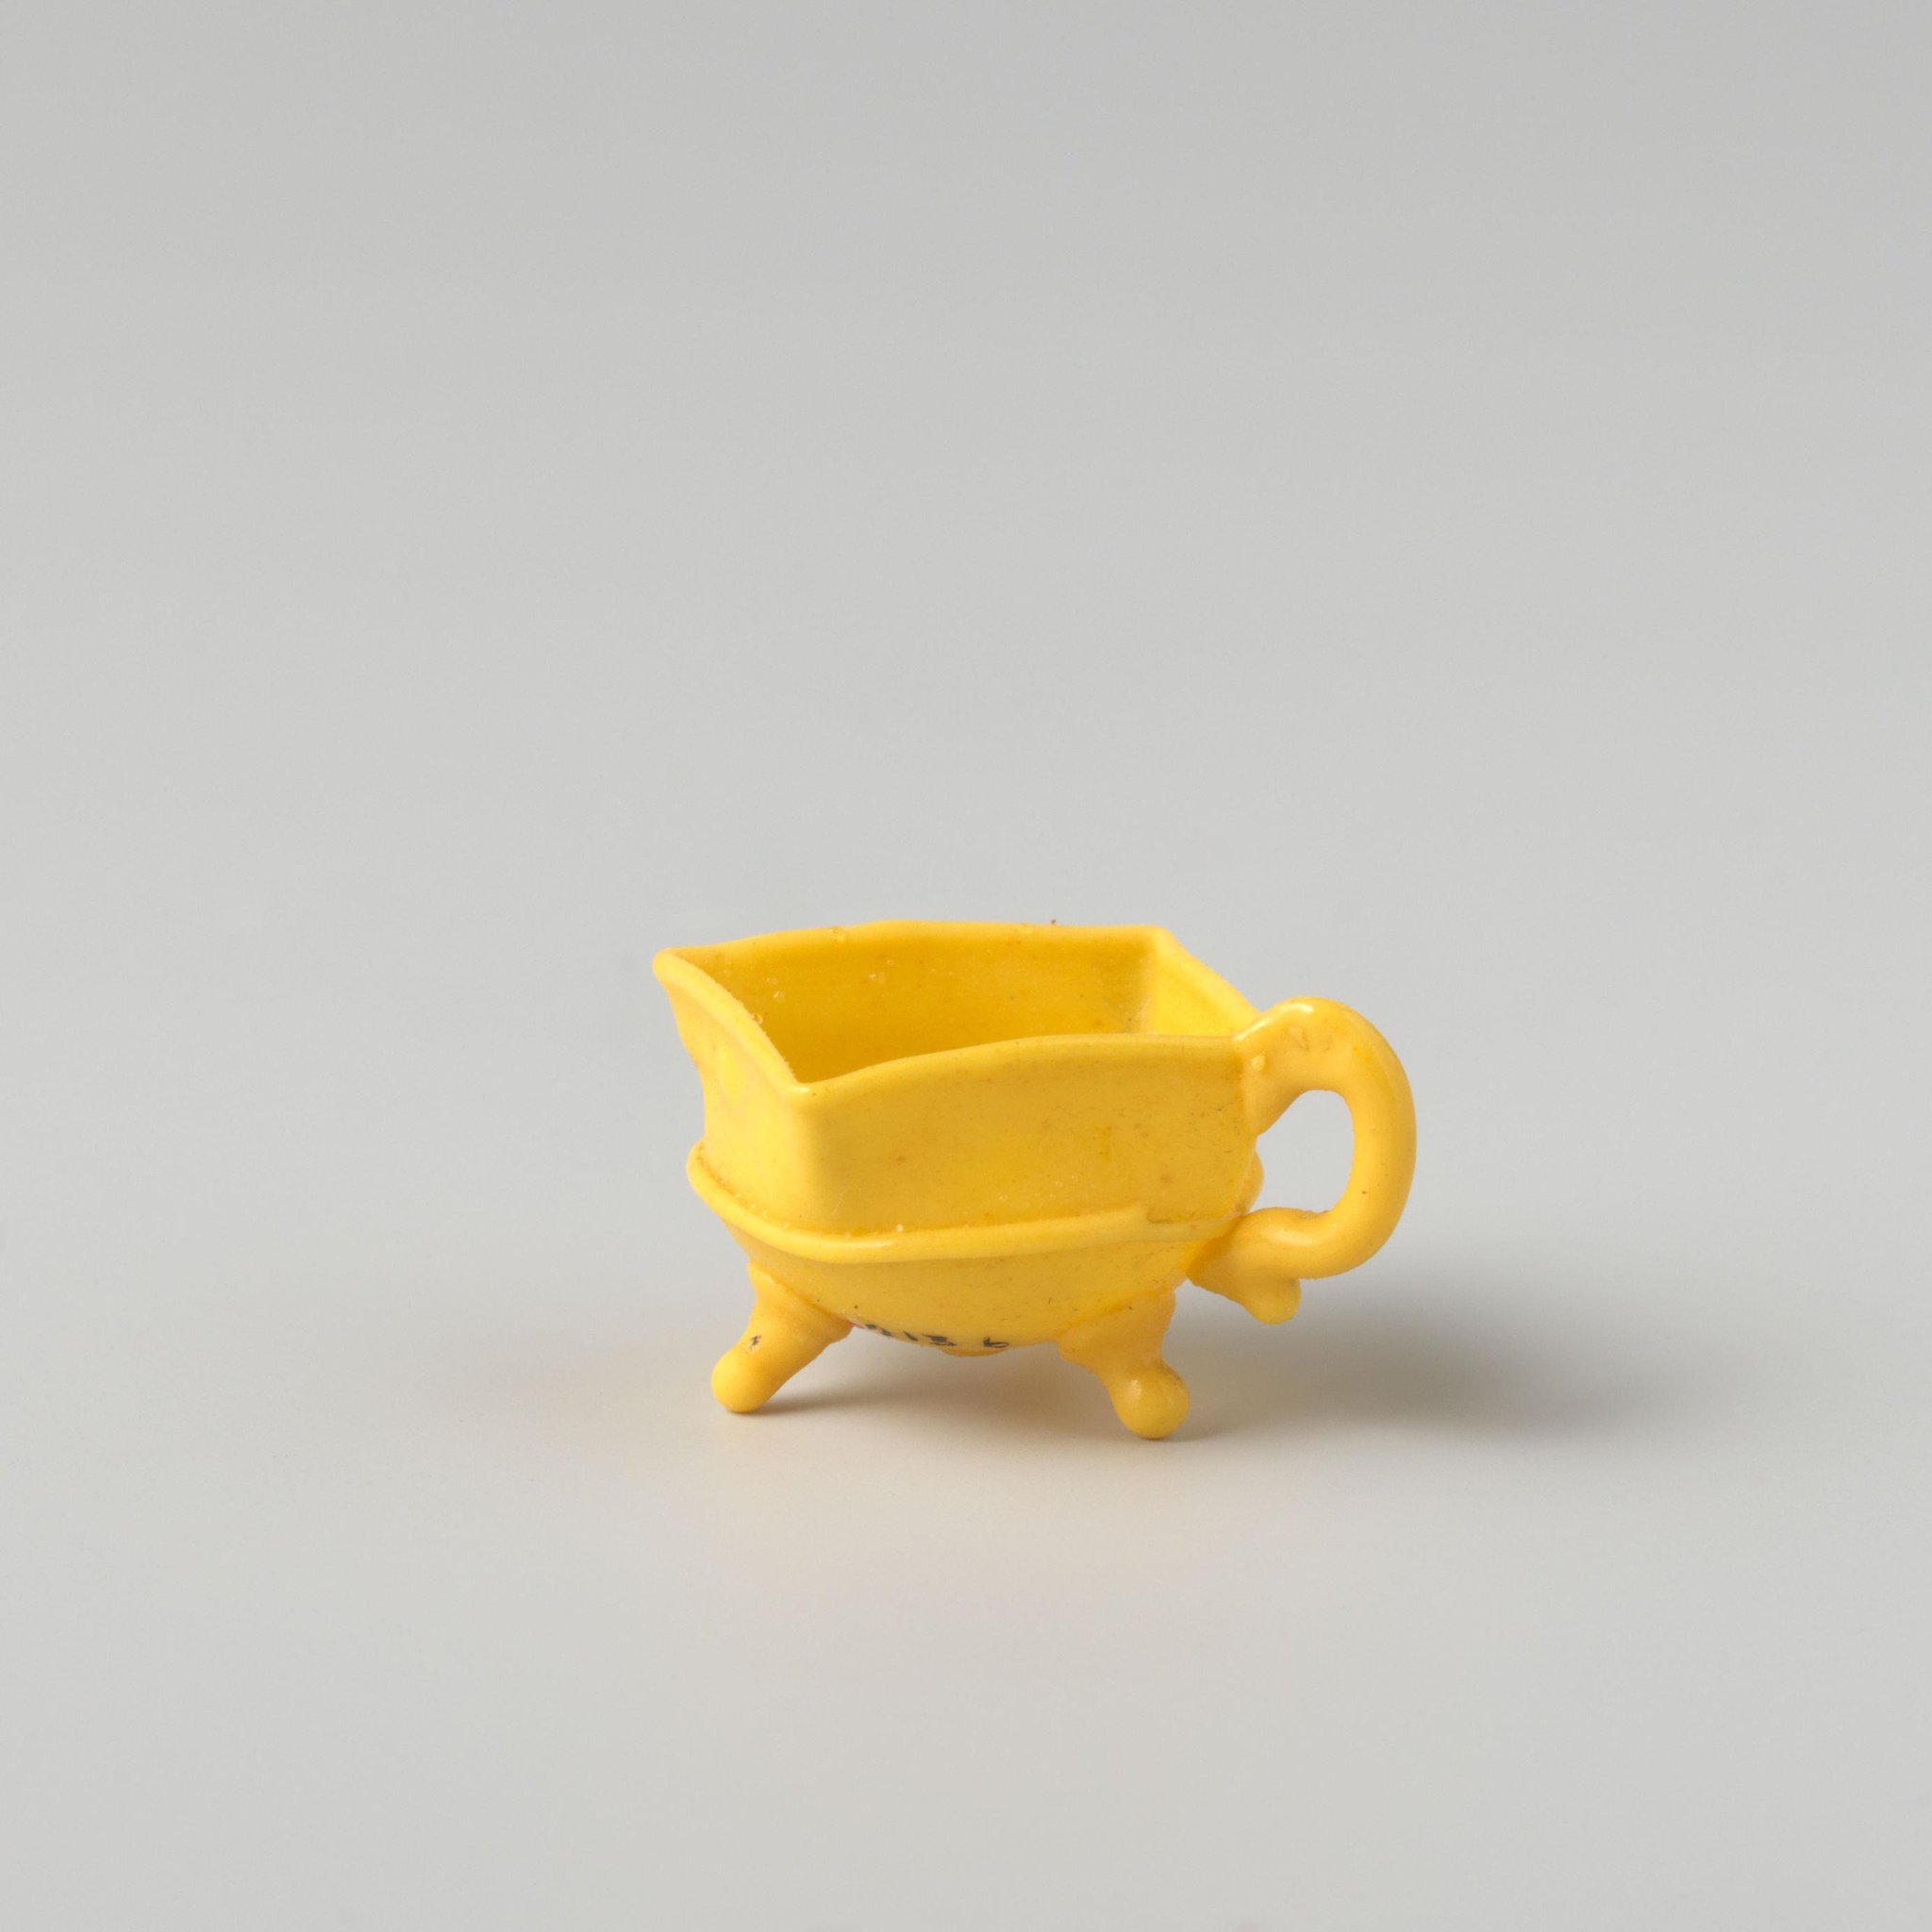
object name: miniature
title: Vierkante vuurtest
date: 1675-1700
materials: glass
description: Vierkante vuurtest op drie poten, van opaak geel glas.